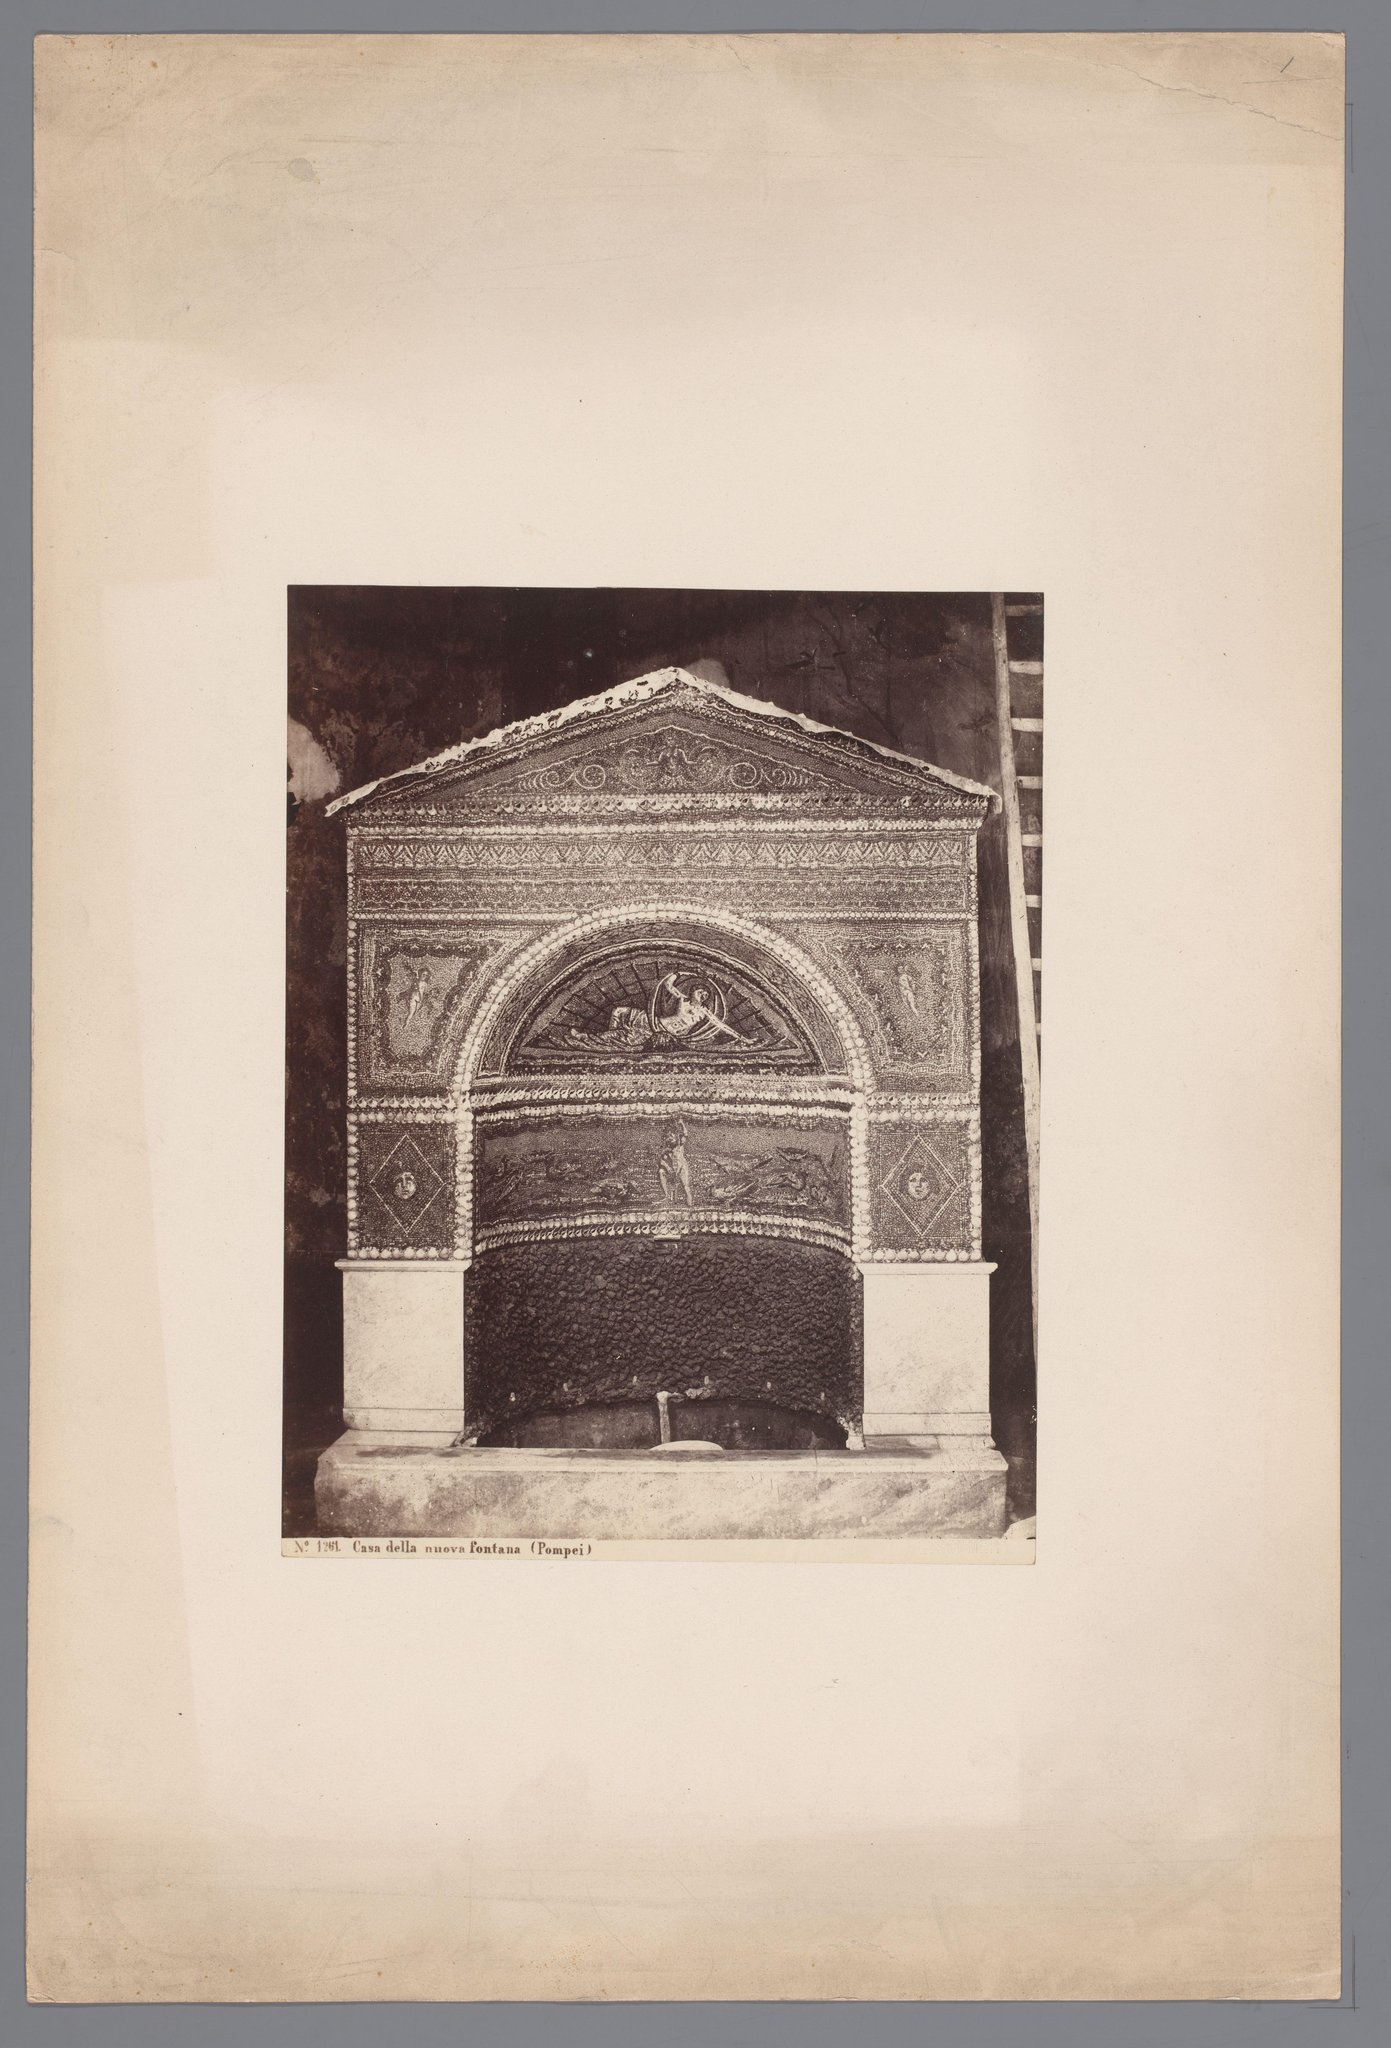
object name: photograph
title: Casa della nuova fontana (Pompei)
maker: giorgio sommer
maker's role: fotograaf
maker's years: 1834-1914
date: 1857-1875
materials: cardboard, paper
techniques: albumen print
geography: pompeii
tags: urban housing, ornamental fountain, work of monumental art, pompeii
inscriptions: collector's mark: ‘RIJKS SCHOOL VOOR KUNSTNIJVERHEID/ GROEP’, number: ‘No. 1261.’, number: ‘21’